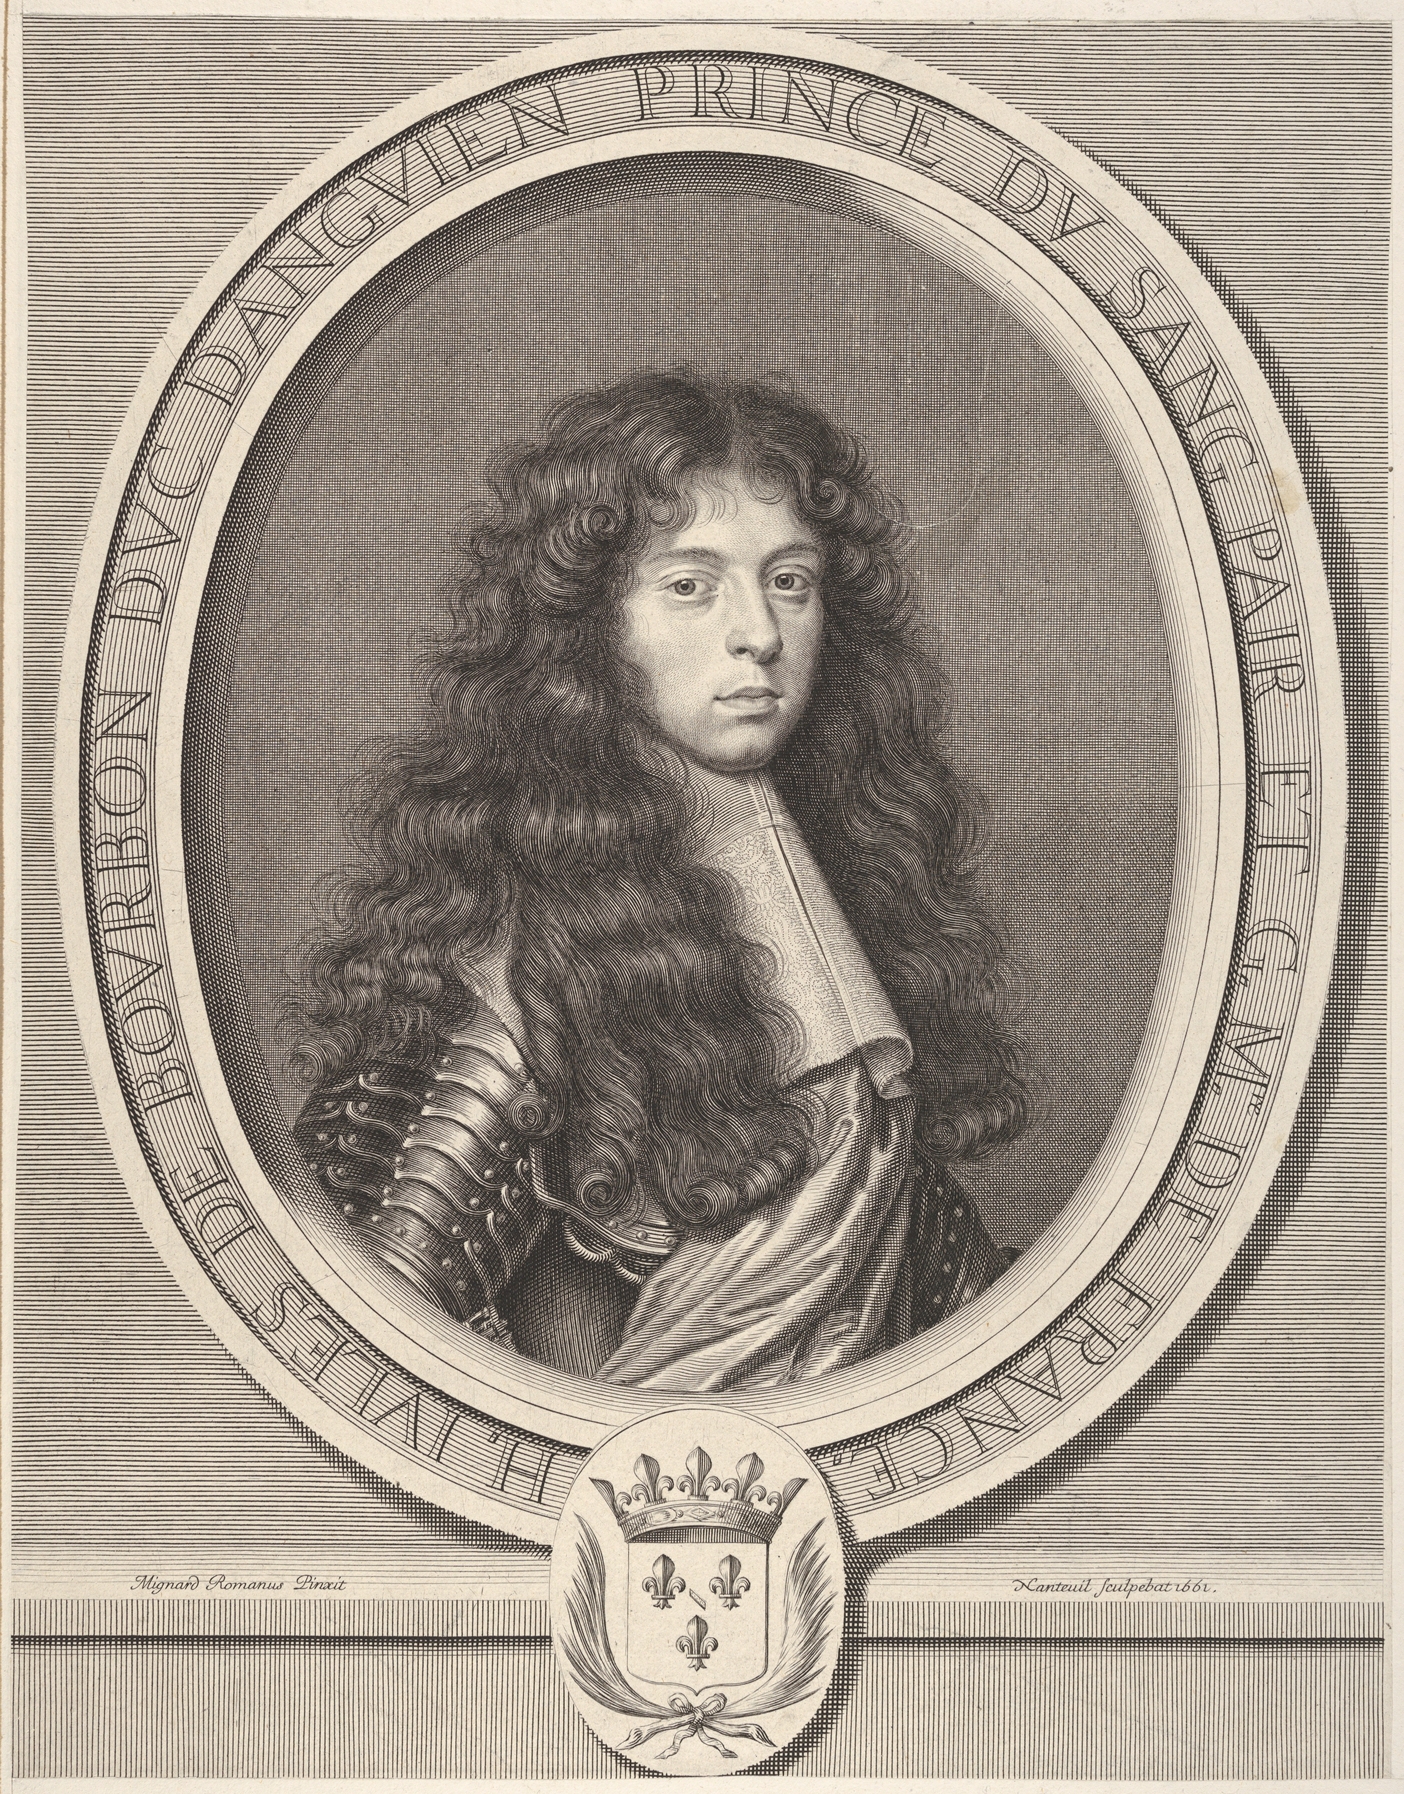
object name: print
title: Henri-Jules de Bourdon, duc d'Enghien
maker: robert nanteuil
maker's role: artist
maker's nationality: french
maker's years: 1623-1678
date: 1661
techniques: engraving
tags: men,portraits